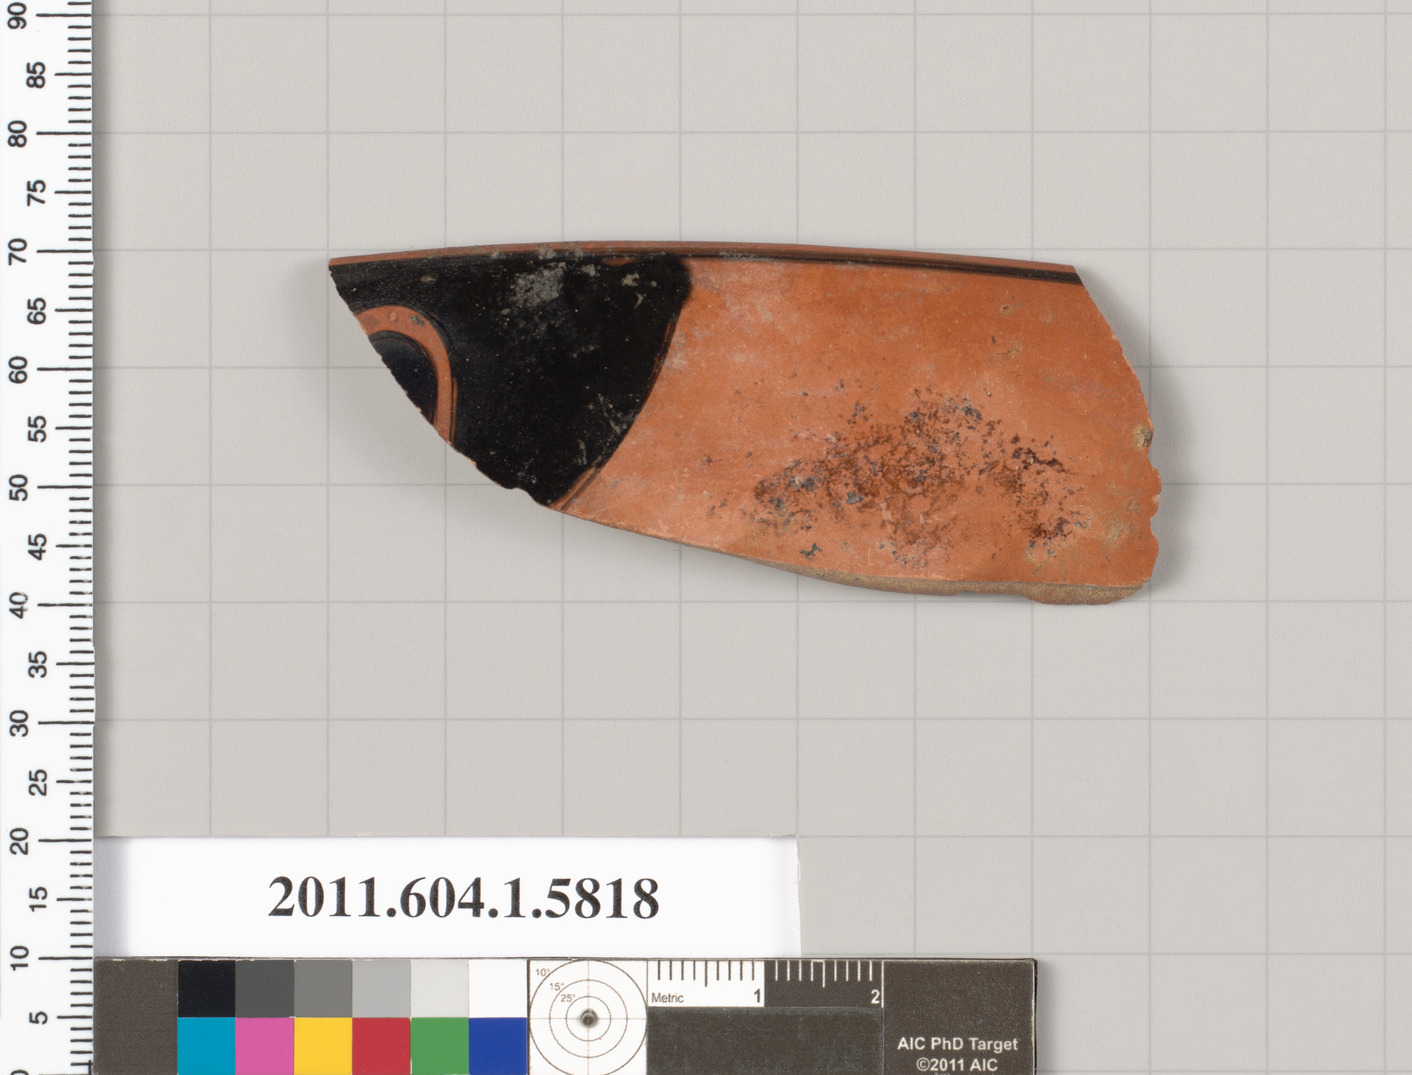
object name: kylix fragment, eye cup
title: Terracotta rim fragment of a kylix: eye-cup (drinking cup)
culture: greek, attic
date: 520-510 BCE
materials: terracotta